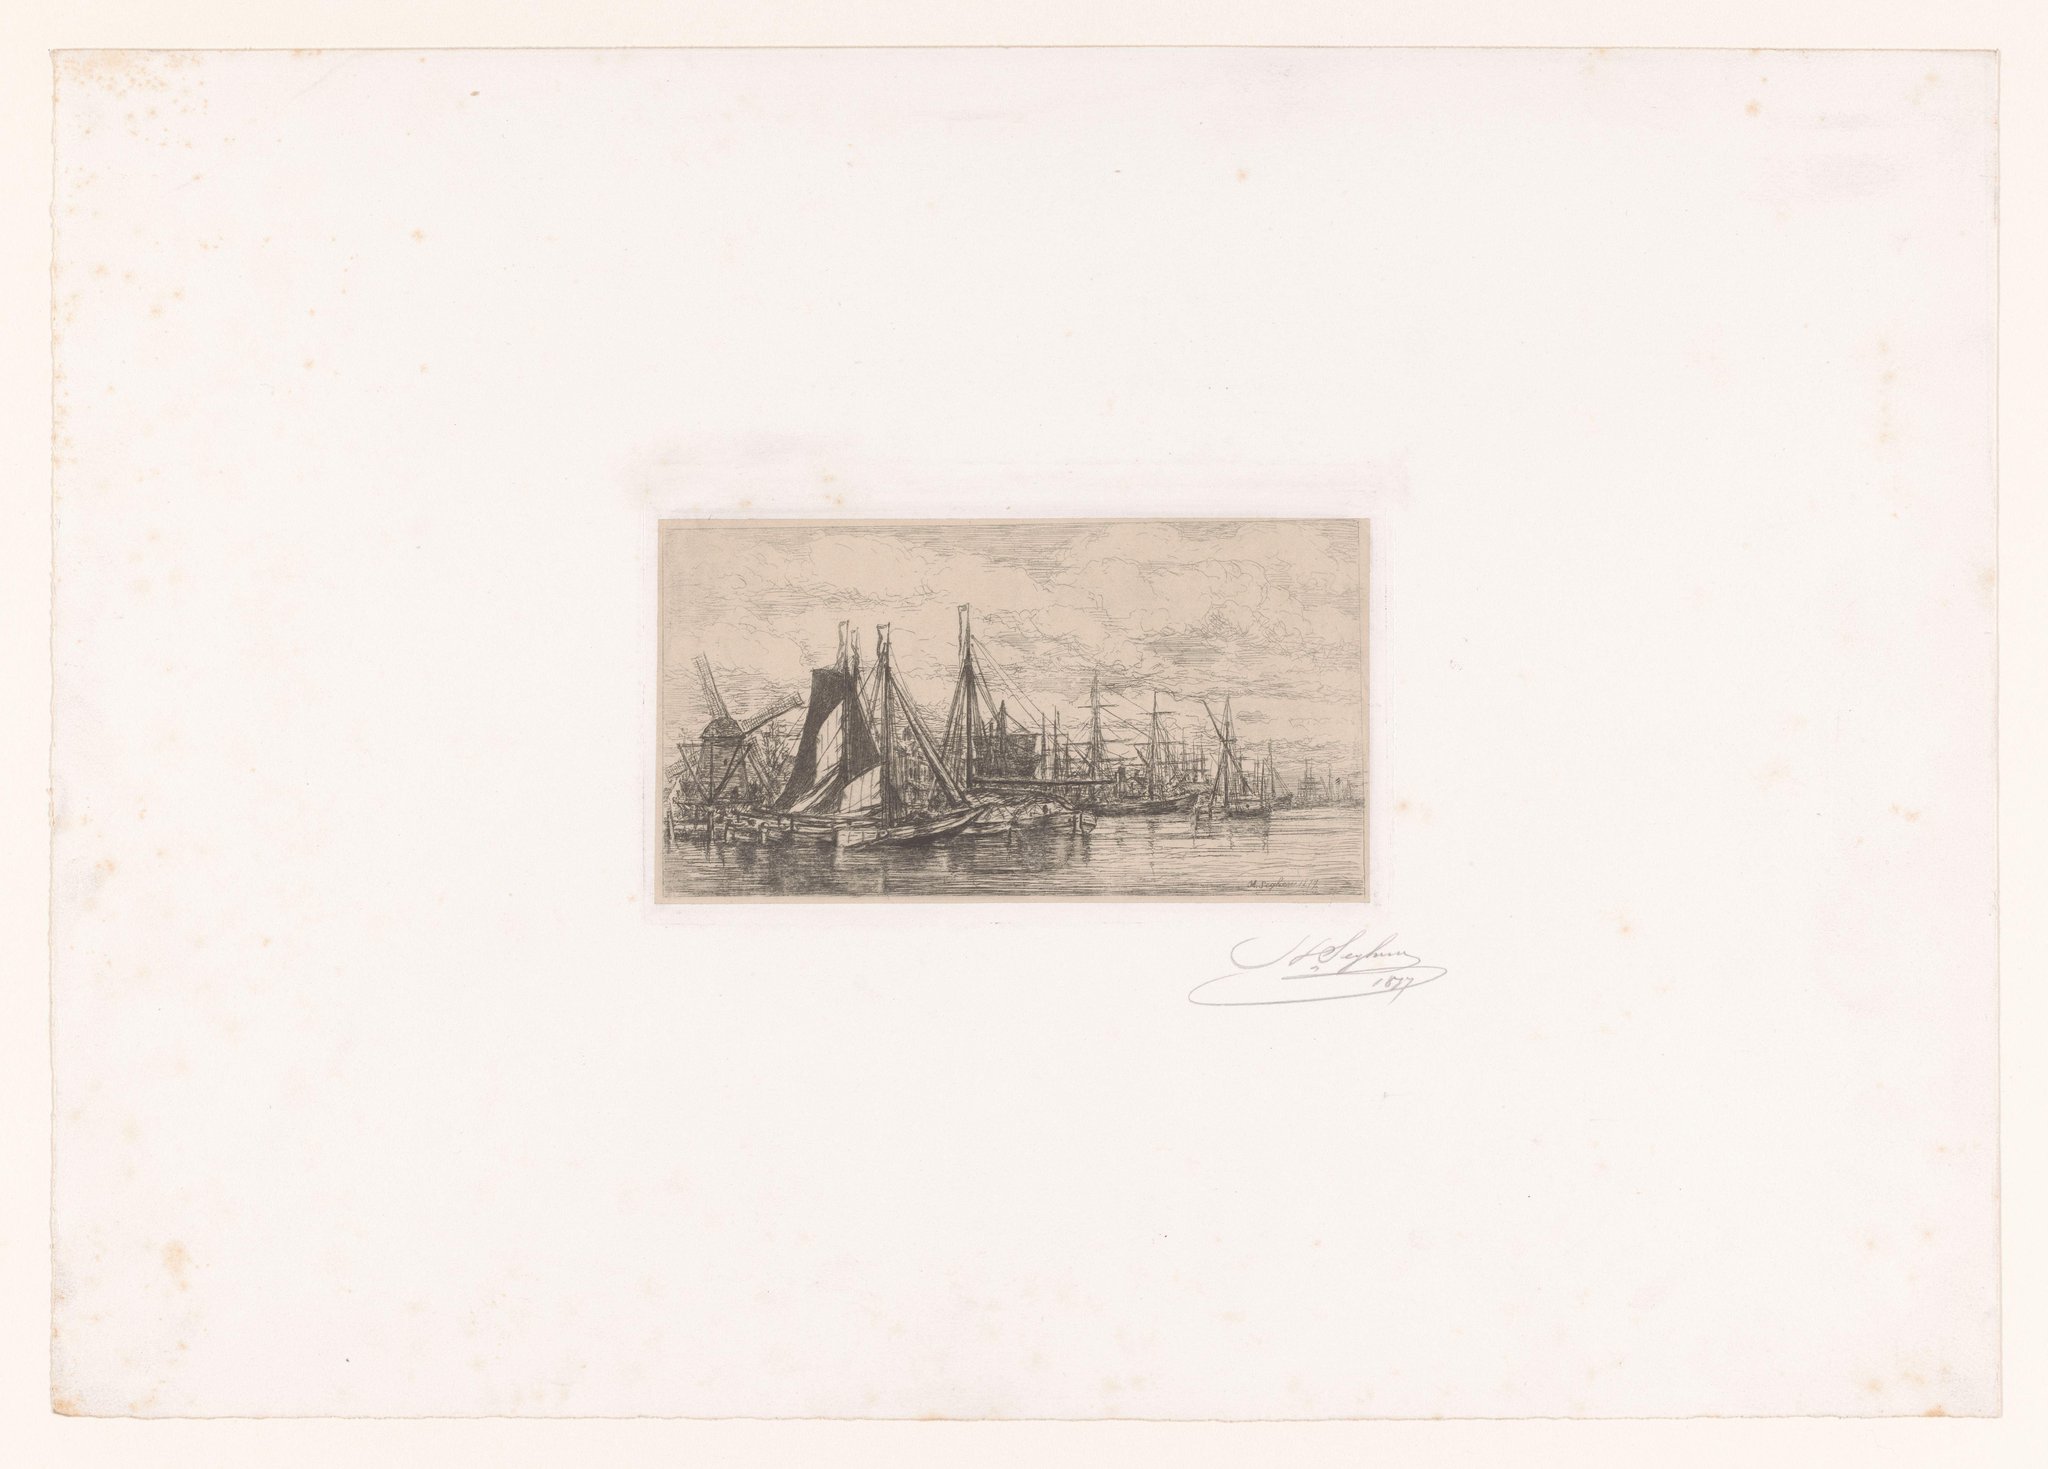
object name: print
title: Gezicht op een haven vol zeilschepen en een molen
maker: henri seghers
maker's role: draughtsman, painter, print maker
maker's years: 1848-1919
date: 1877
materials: paper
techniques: drypoint, etching, intaglio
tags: harbour, sailing-ship, sailing-boat, windmill in landscape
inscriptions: collector's mark: Lugt 2228